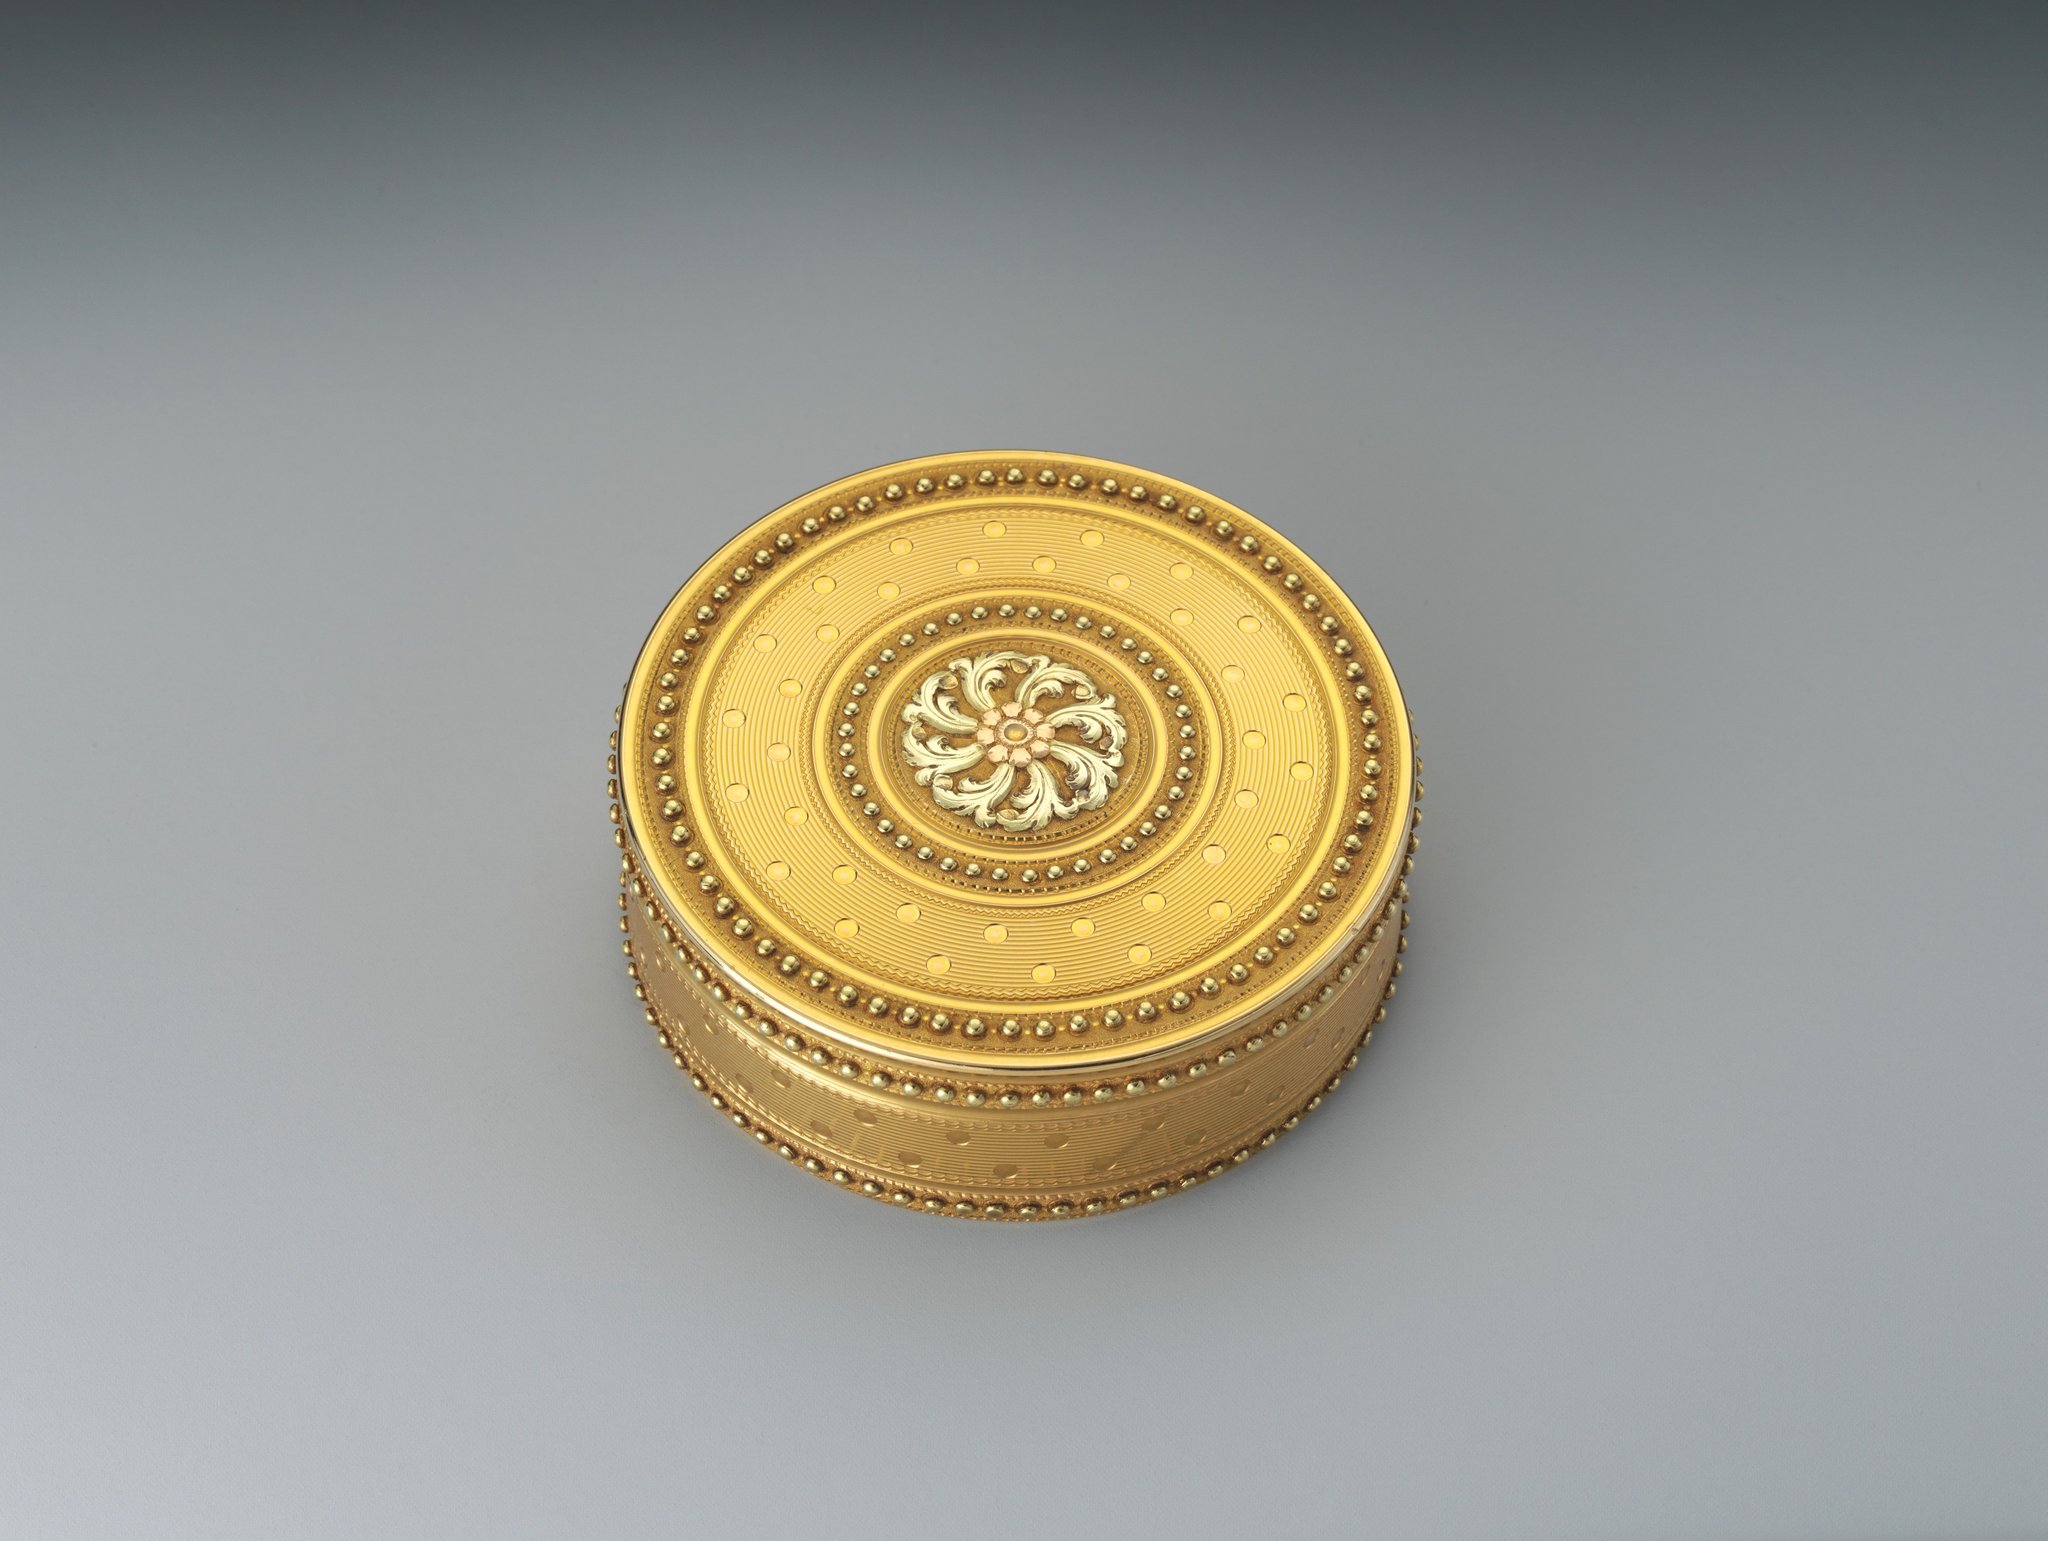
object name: box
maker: françois-nicolas chevance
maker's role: maker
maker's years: 1766-1780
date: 1781-1782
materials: gold